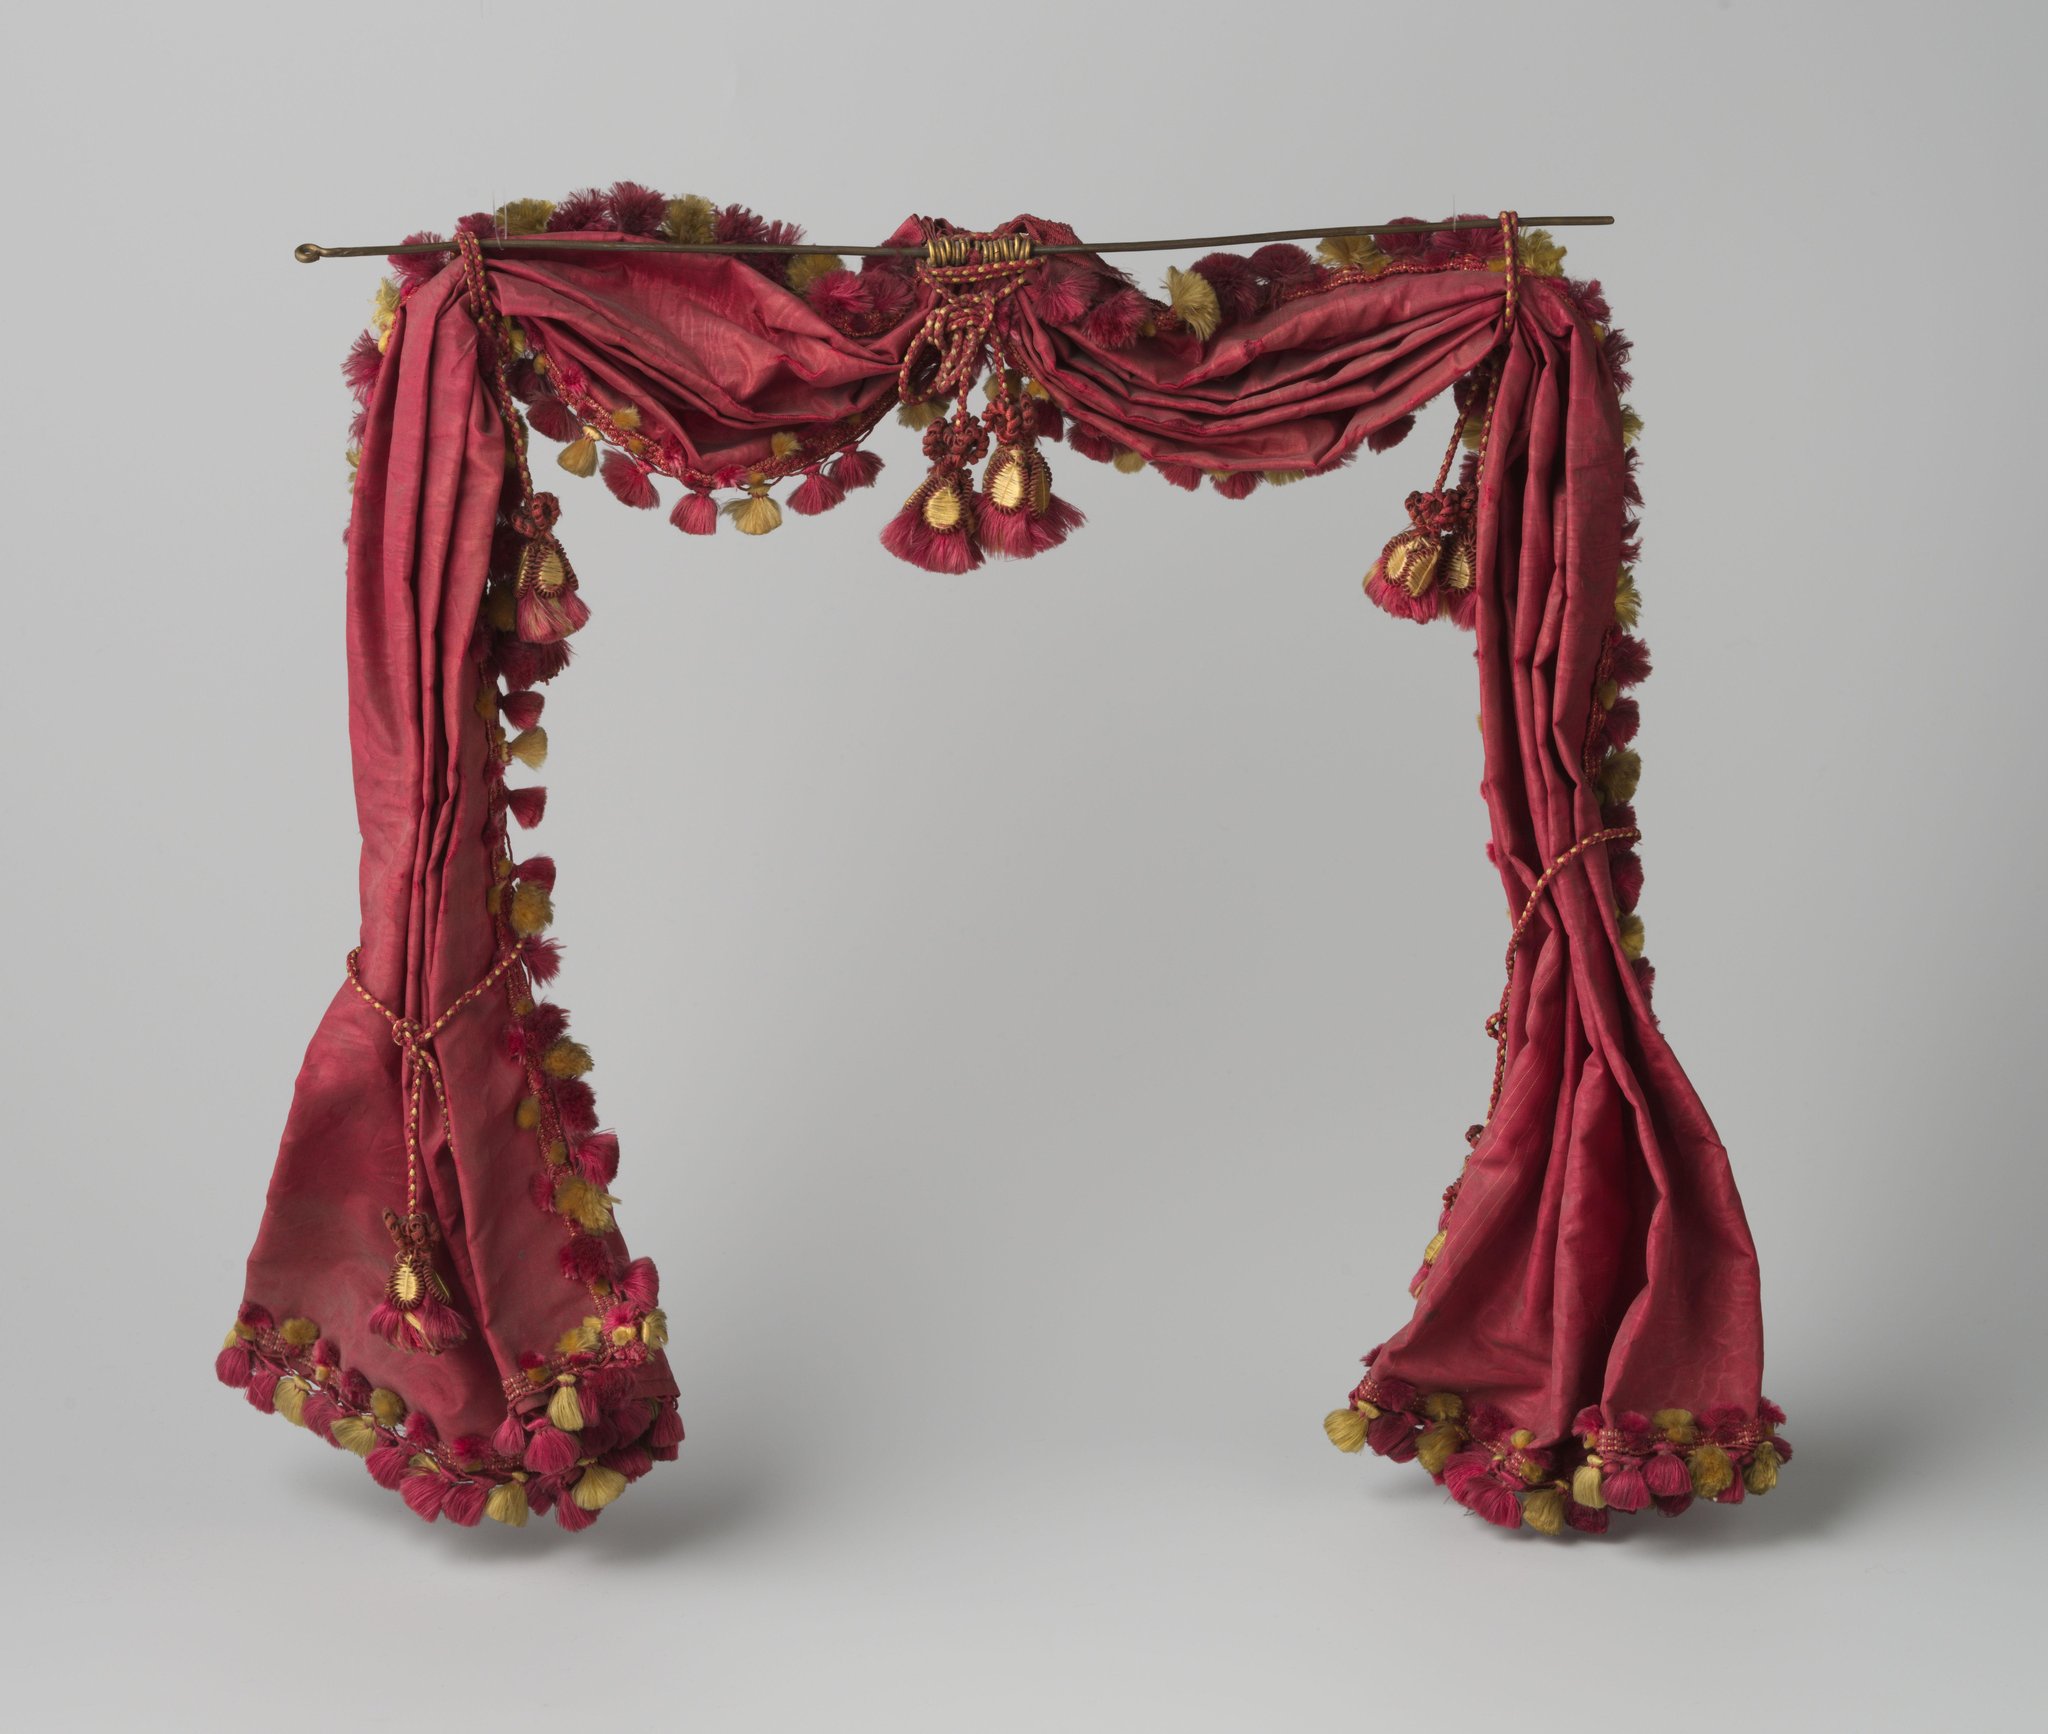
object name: miniature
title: Alkoof-gordijn, vervaardigd van roze-rode moiré zijde, aan alle kanten afgezet met passement met gele en rode kwasten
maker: Anonymous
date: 1690-1710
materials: copper, silk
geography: amsterdam